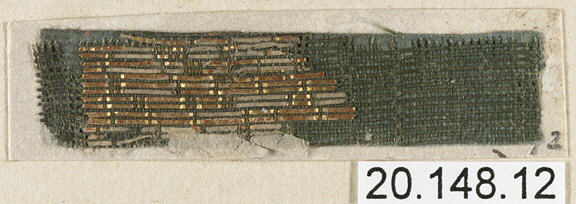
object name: piece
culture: japanese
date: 1301-1400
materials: silk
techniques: compound weave